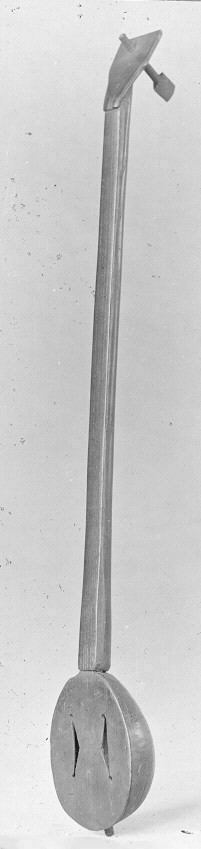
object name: guenbri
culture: syrian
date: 1867-1900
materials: plant material, wood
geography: syria